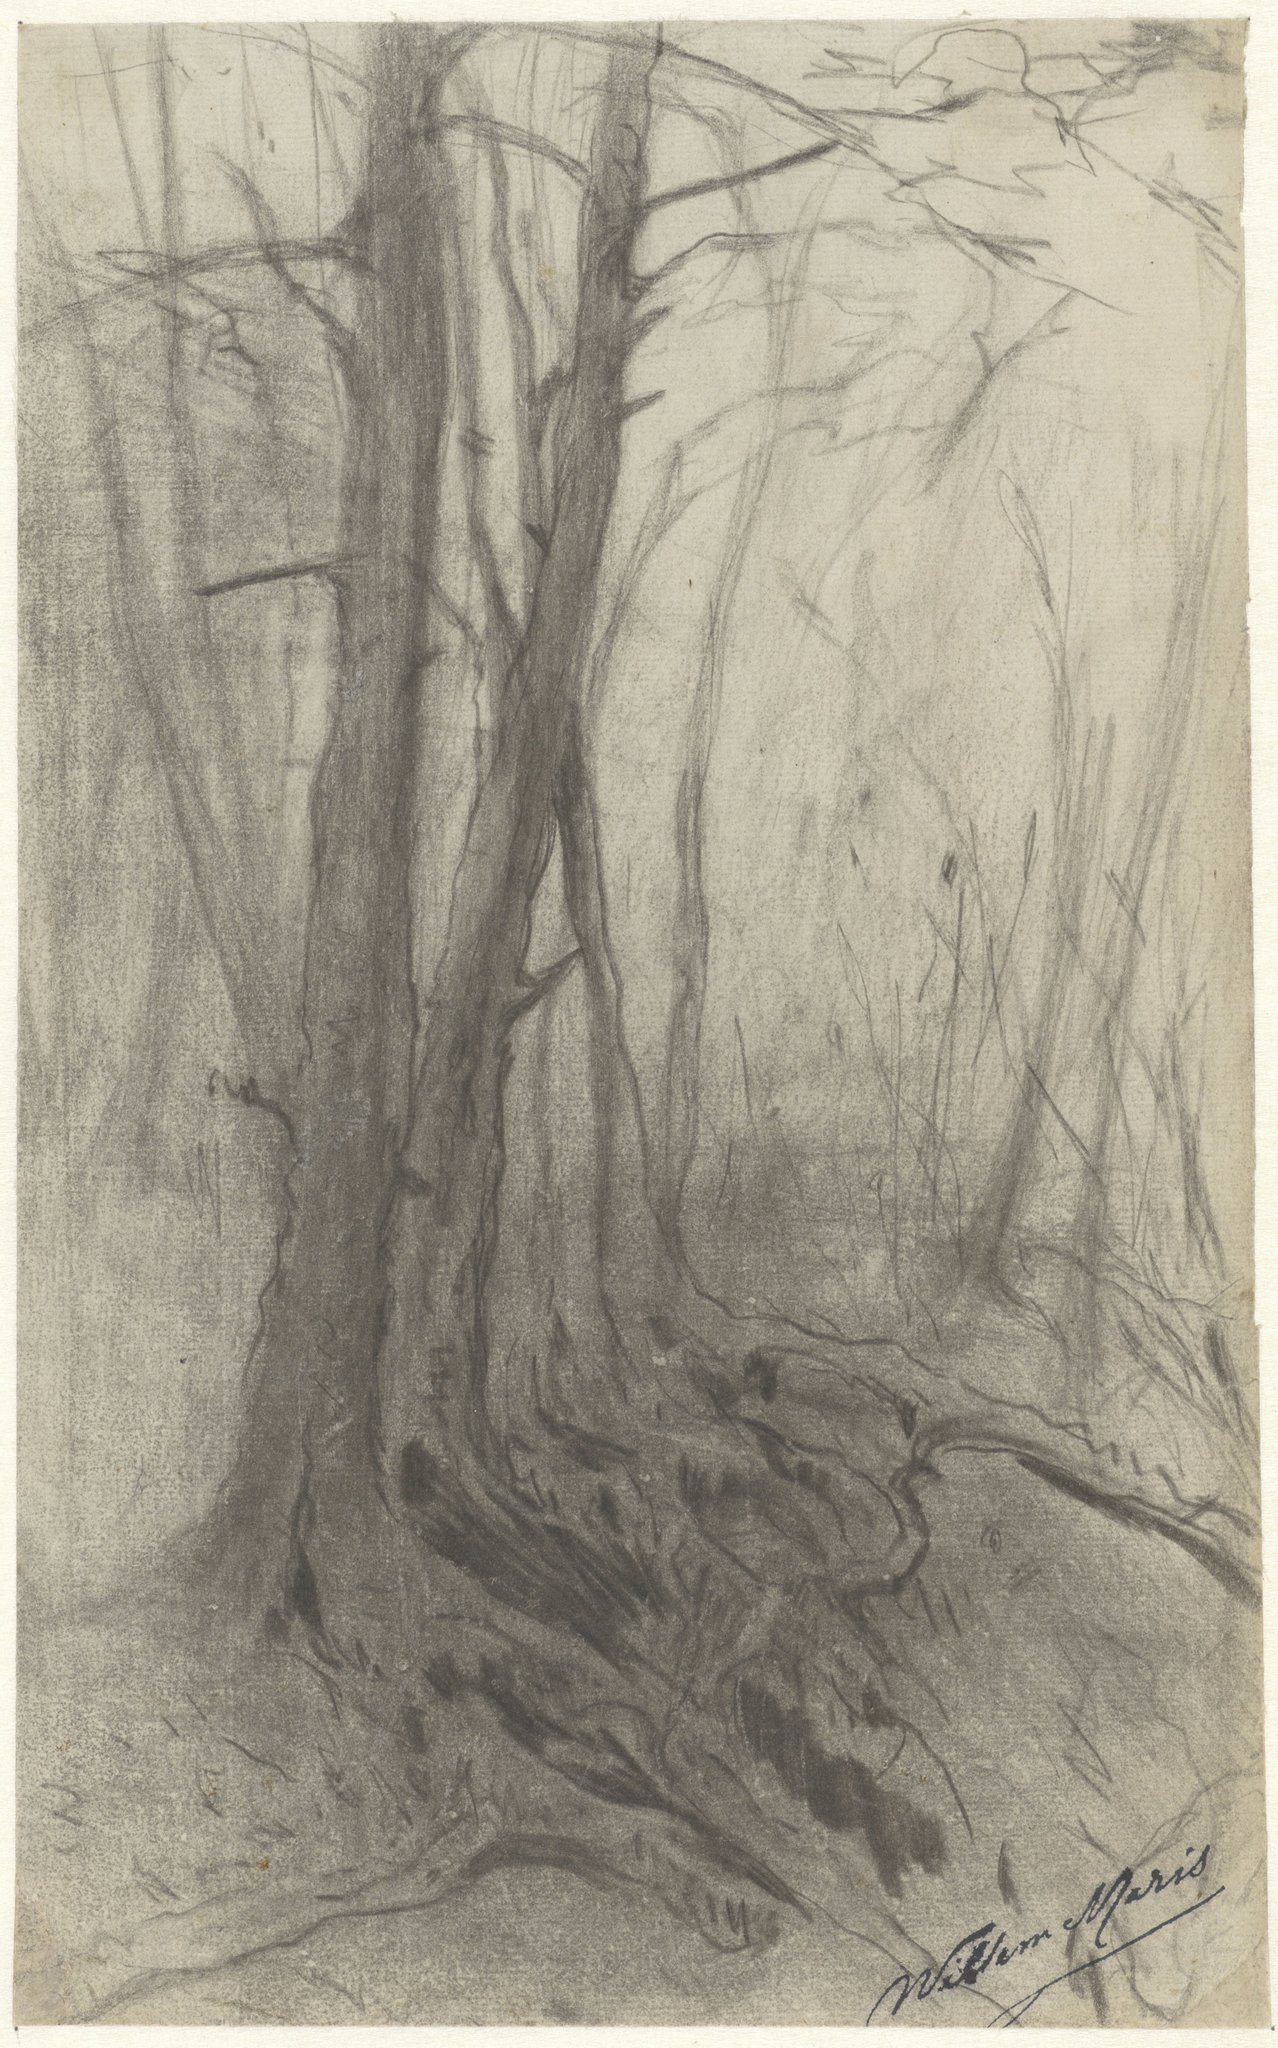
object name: drawing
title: Bomen in een bos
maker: willem maris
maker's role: draughtsman, painter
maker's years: 1844-1910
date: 1854-1910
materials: chalk, paper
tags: trees, forest, wood